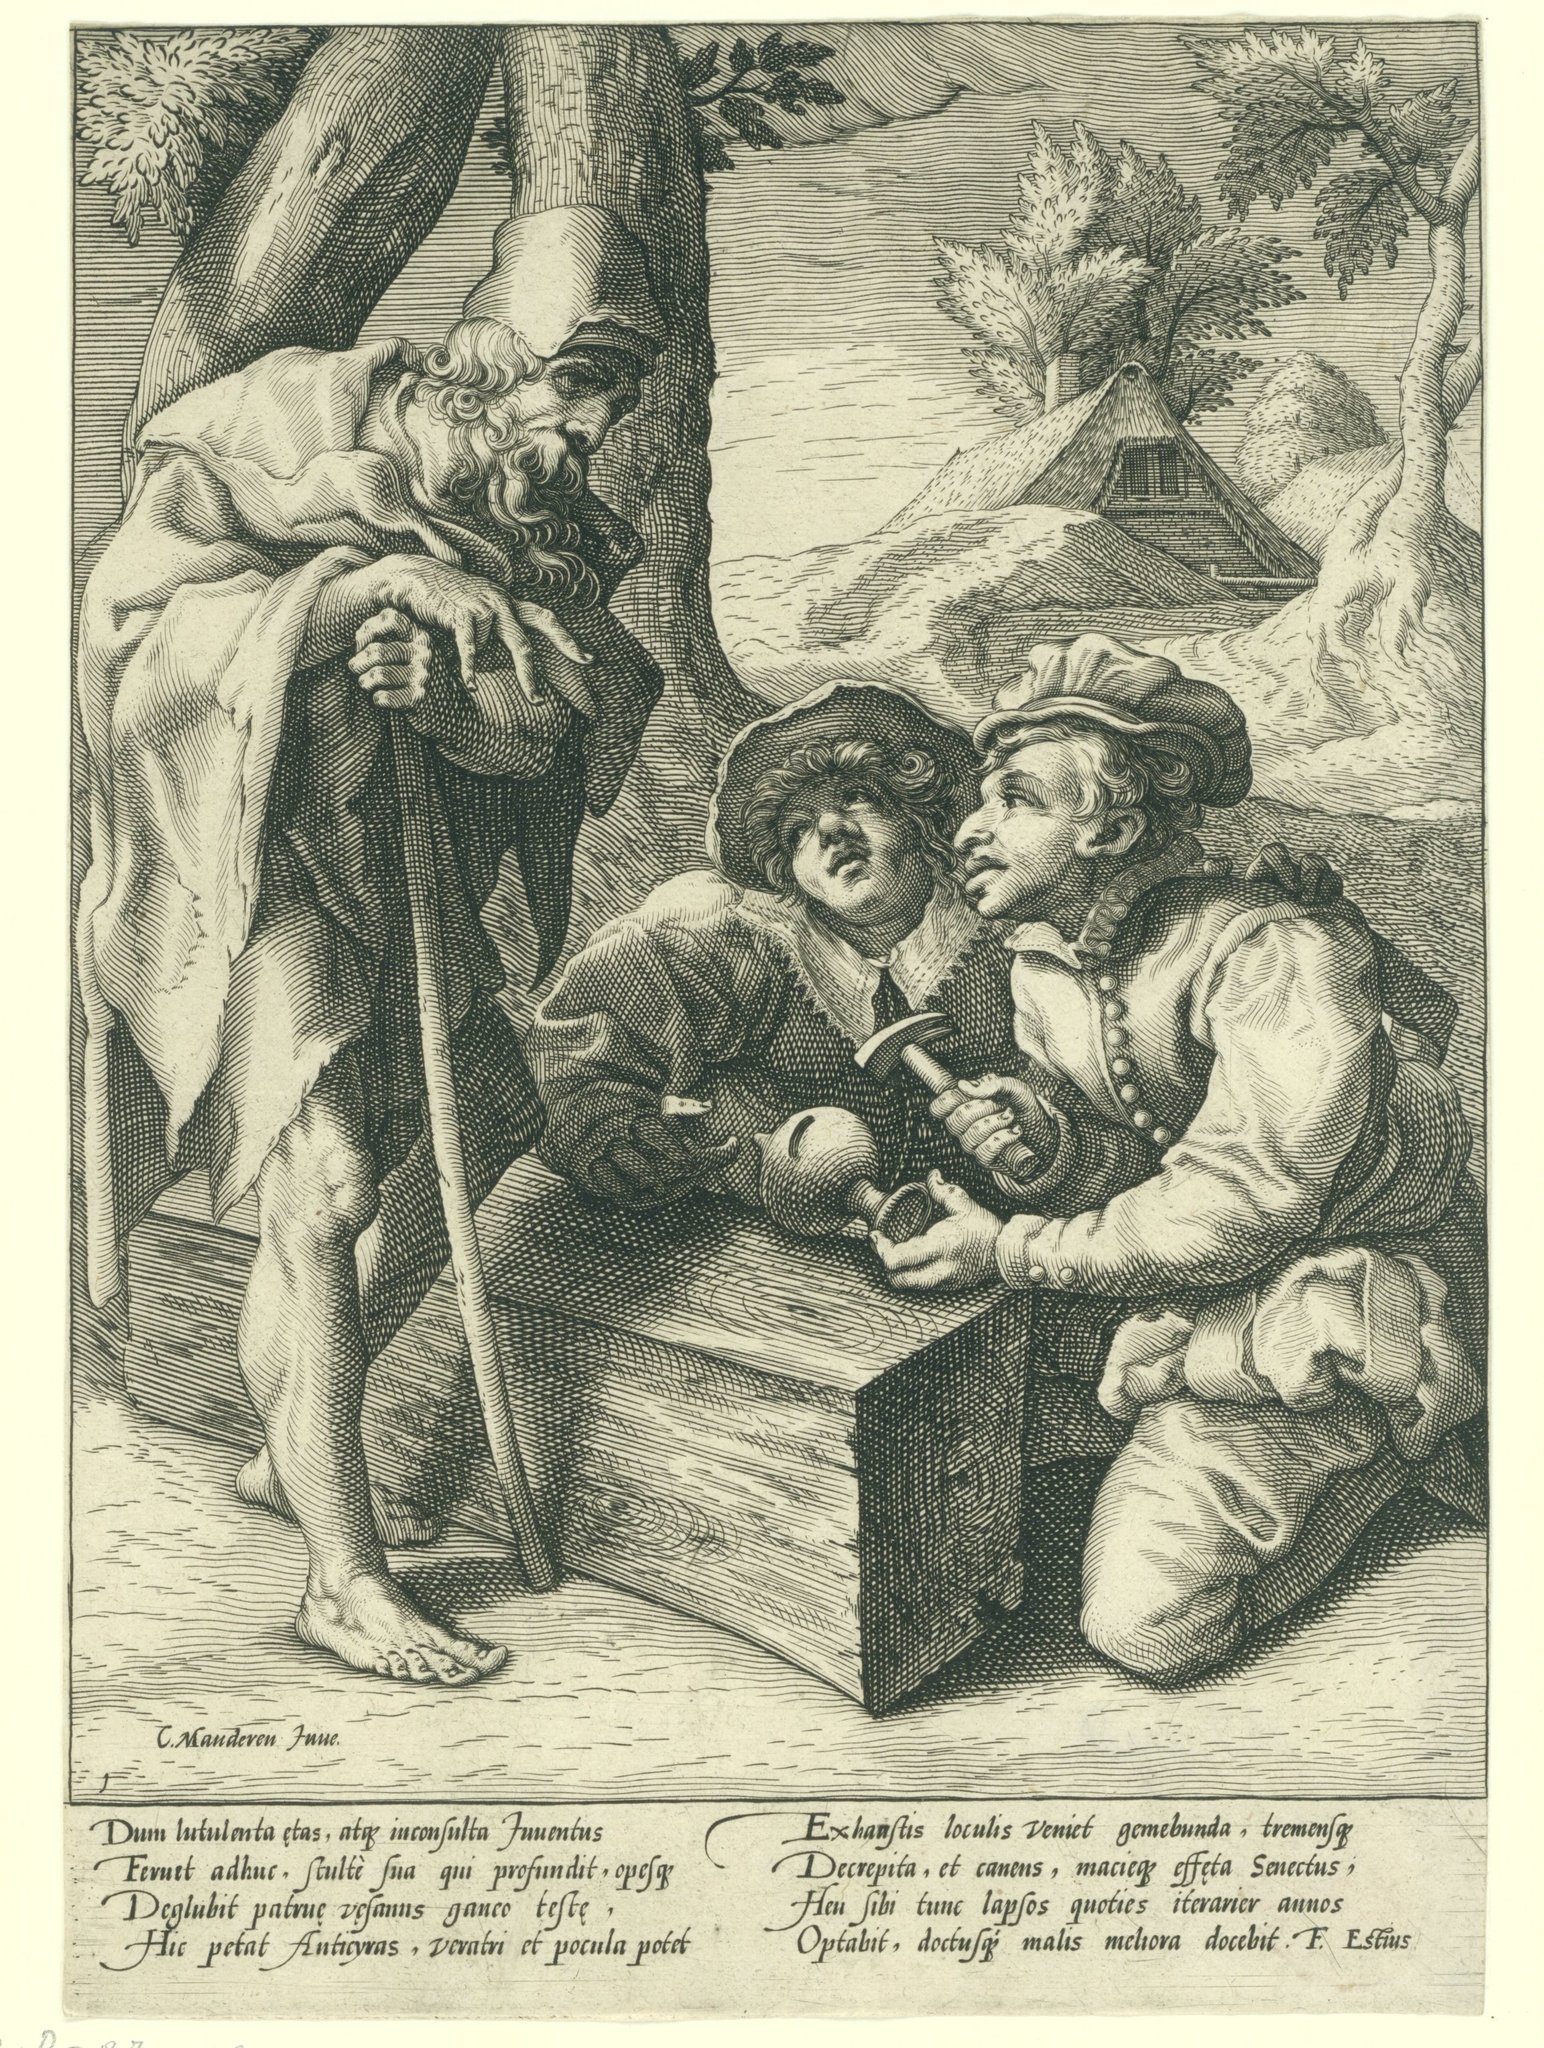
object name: print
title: Spreekwoorden naar Karel van Mander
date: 1590-1594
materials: paper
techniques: engraving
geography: haarlem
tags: proverbs, sayings, etc., money-chest, treasure-chest, money-box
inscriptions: collector's mark: Lugt 240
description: Twee jongens staan op het punt om hun spaarpot stuk te slaan met een hamer. Een arme oude man die op een stok leunt wijst hen erop dat ze misschien nog beter even kunnen blijven sparen. Anders vergaat het hen als hem. De man maakt een spreekgebaar met drie uitgestrekte vingers.